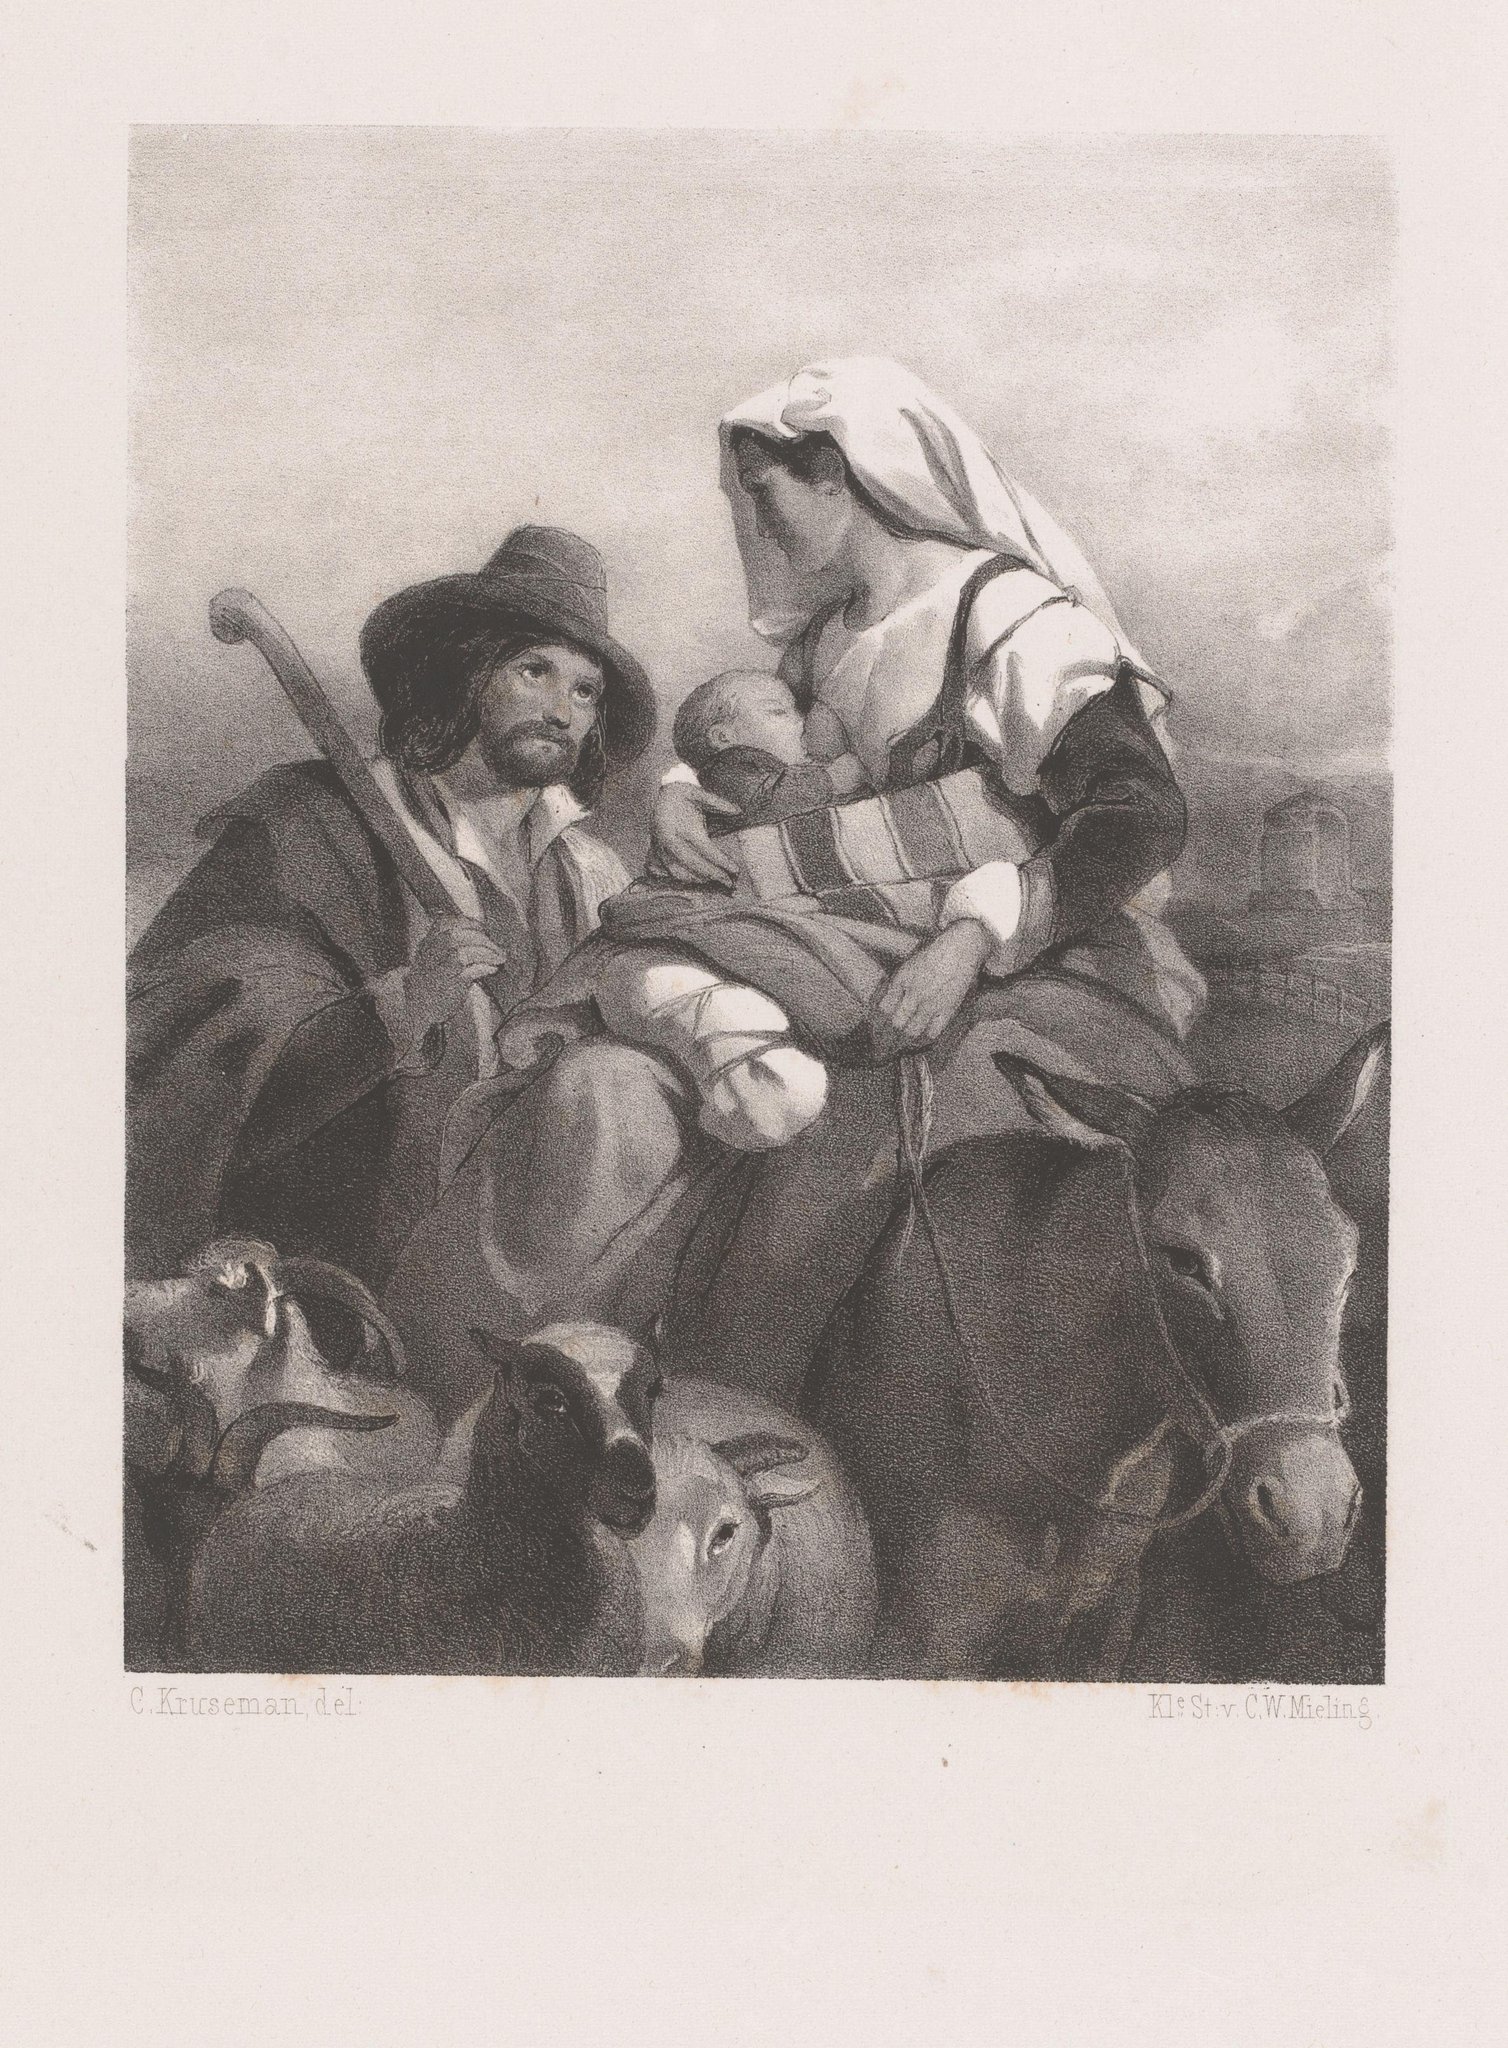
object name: print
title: Huiswaarts kerende herdersfamilie uit de omstreken van Rome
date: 1847-1857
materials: paper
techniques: lithograph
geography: the hague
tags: the flight into egypt: mary, joseph, the child (and sometimes others) on their way; mary usually riding on an ass, ass, donkey, herding, herdsman, herdswoman, shepherd, shepherdess, cowherd, etc.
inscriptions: collector's mark: Lugt 2228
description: De vrouw zit op een ezel met een kind aan haar borst. Achter haar loopt haar man.